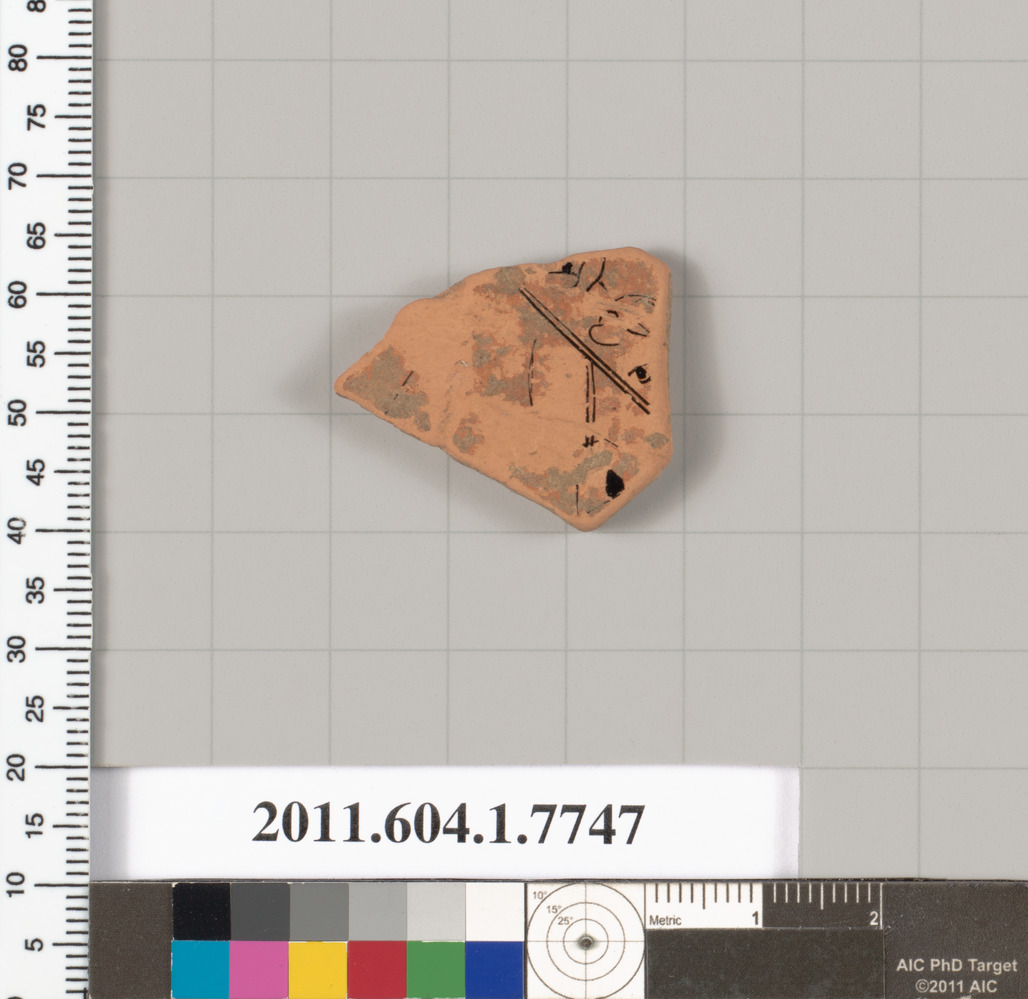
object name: kylix fragment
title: Terracotta fragment of a kylix (drinking cup)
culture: greek, attic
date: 480-460 BCE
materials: terracotta